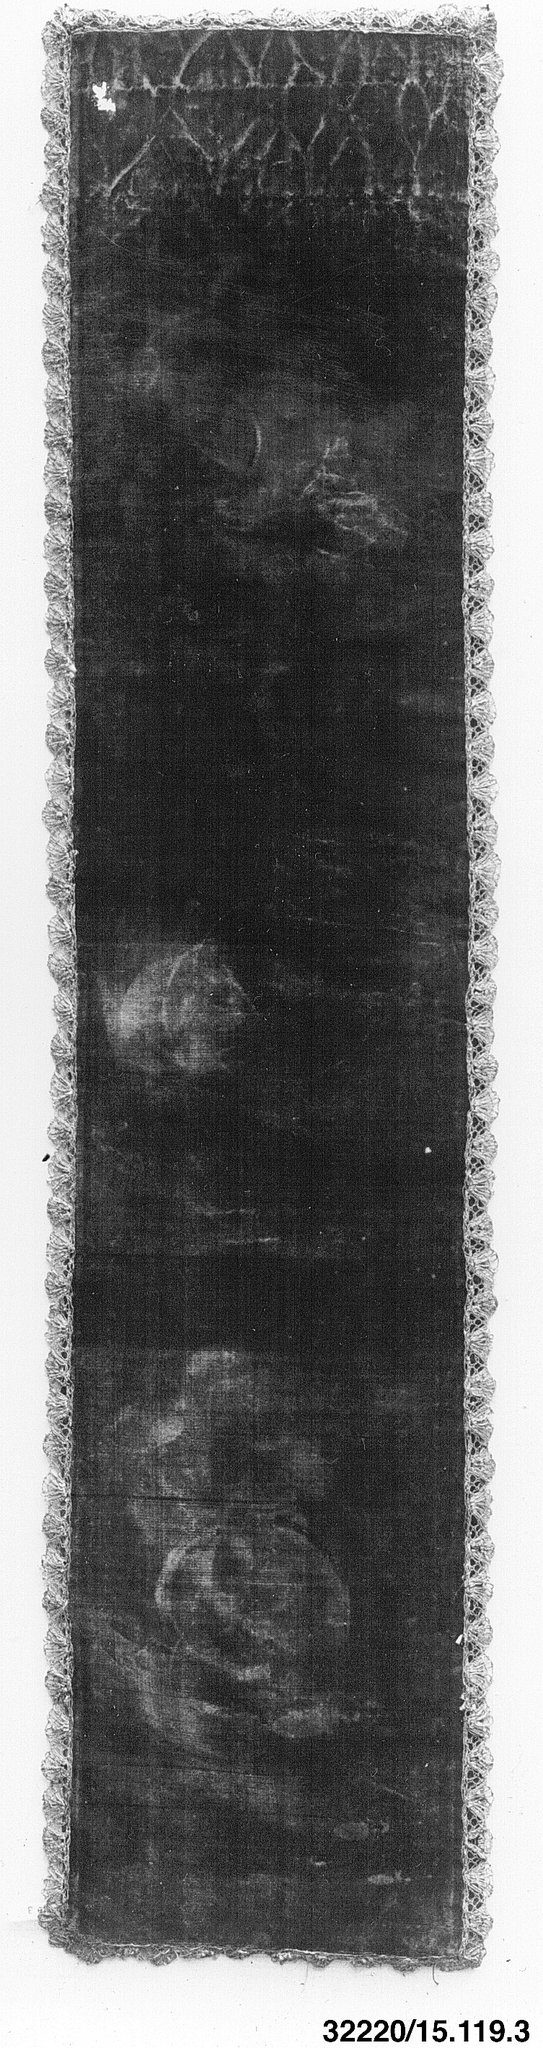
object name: strip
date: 1601-1700